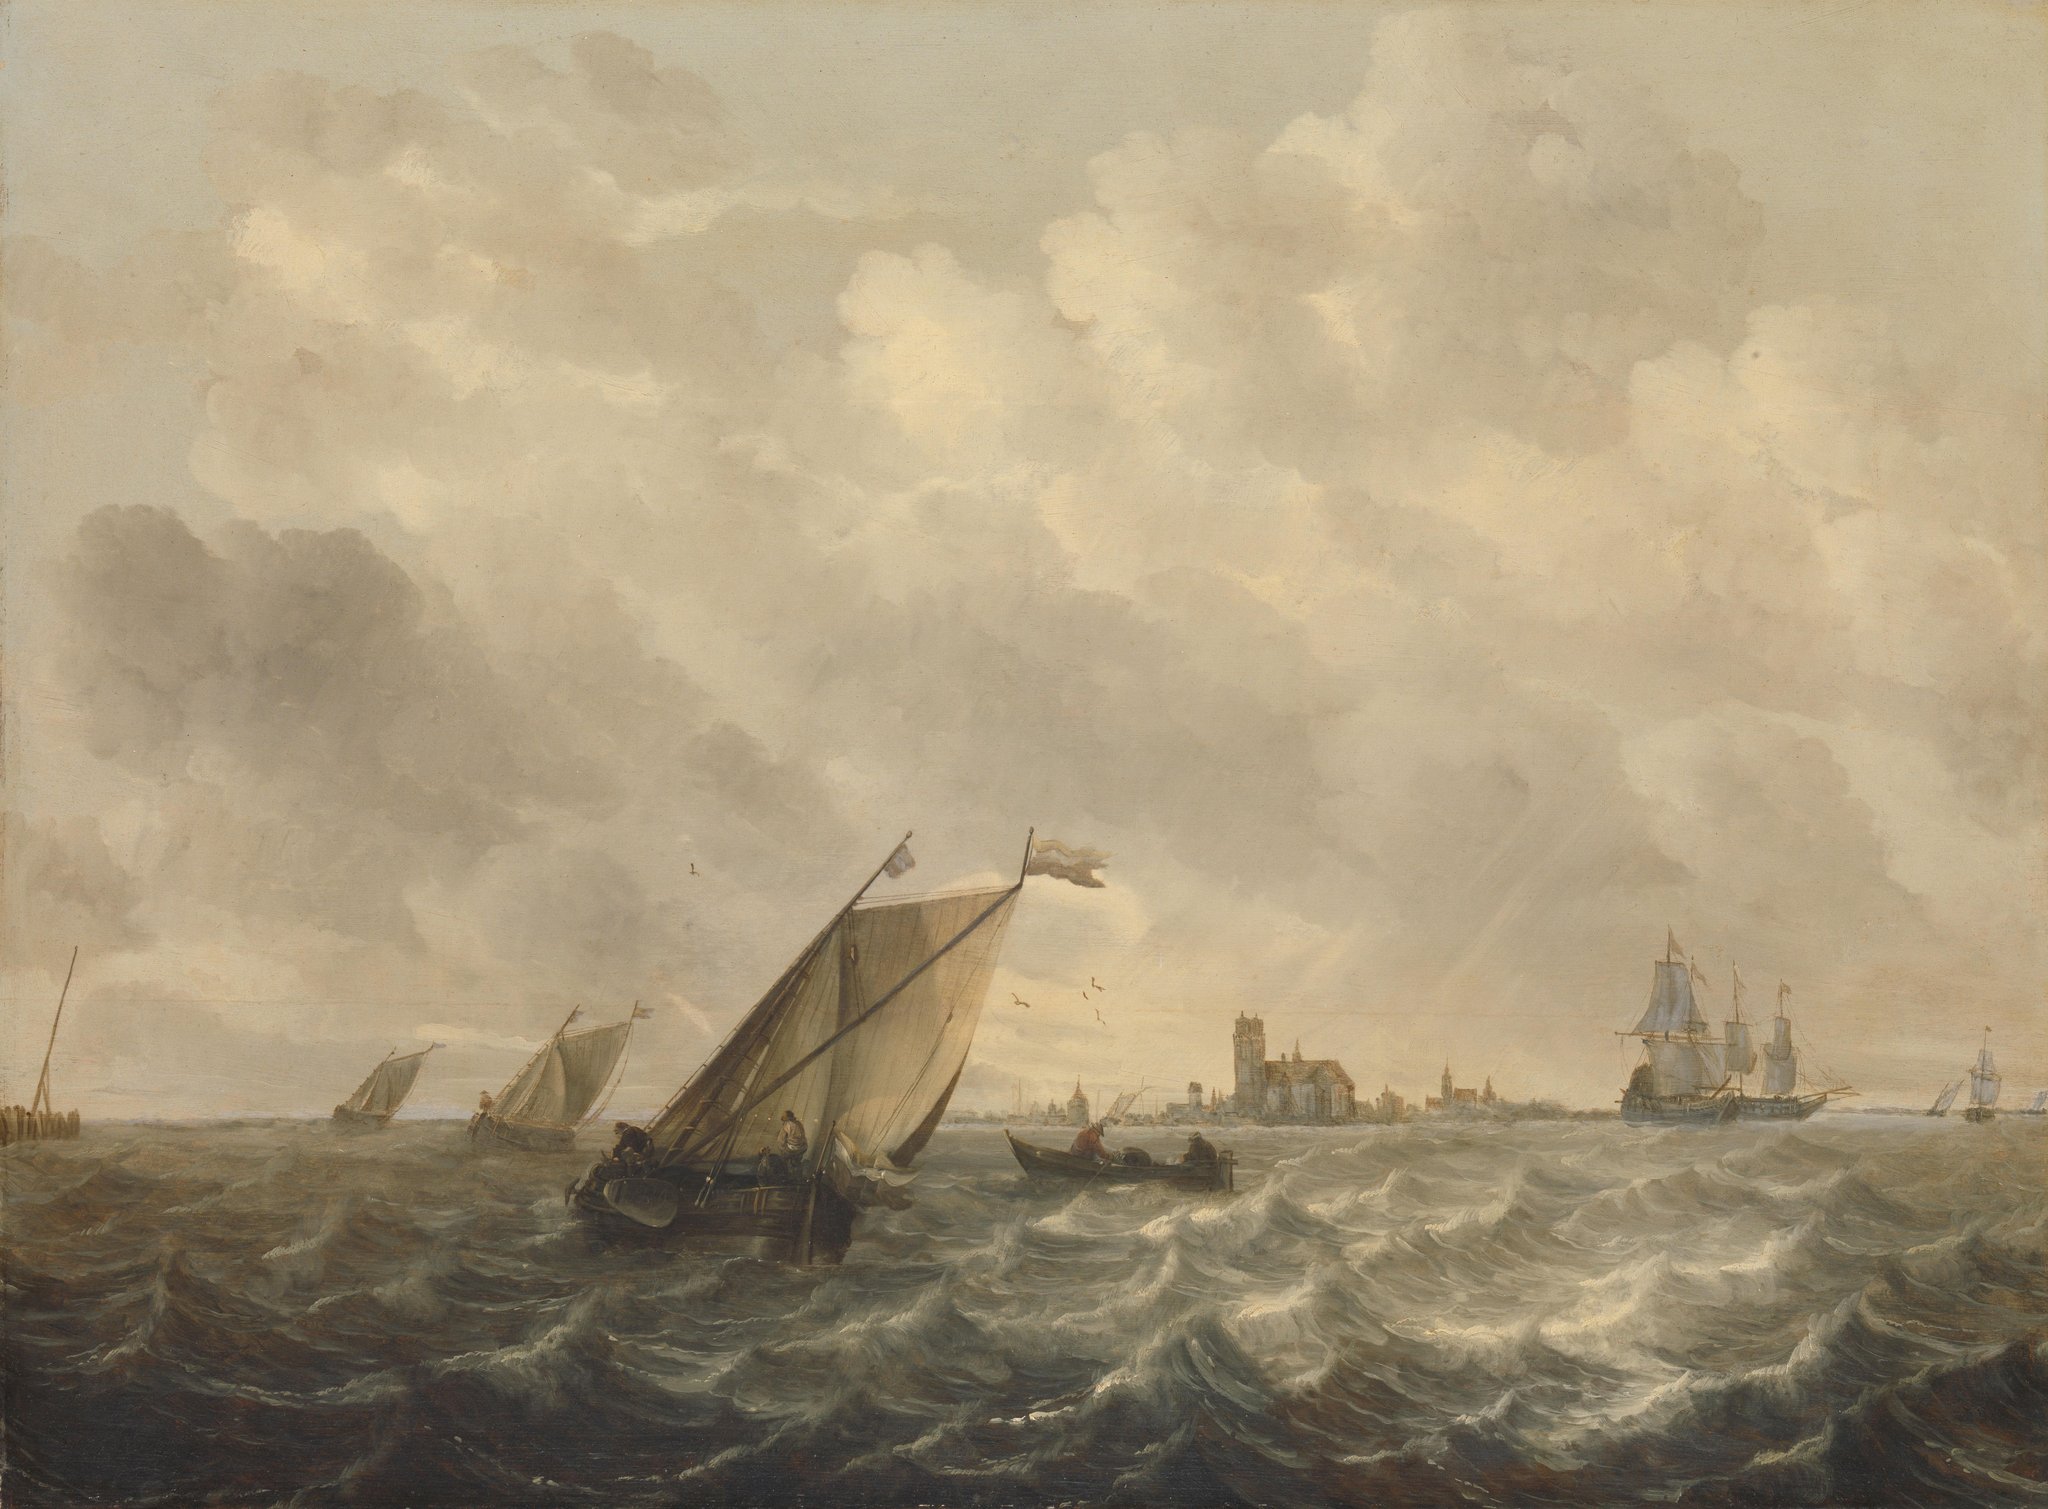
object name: painting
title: River View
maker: abraham van beyeren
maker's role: painter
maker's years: 1620-1690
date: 1643-1650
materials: oil, panel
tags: sailing-ship, sailing-boat, river, dordrecht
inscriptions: signature, with ligated monogram, lower centre, on the leeboard of the sailing boat: ‘AVB F’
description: Riviergezicht. Schepen en bootjes op woelig water met in de verte een stadsprofiel (Dordrecht?).